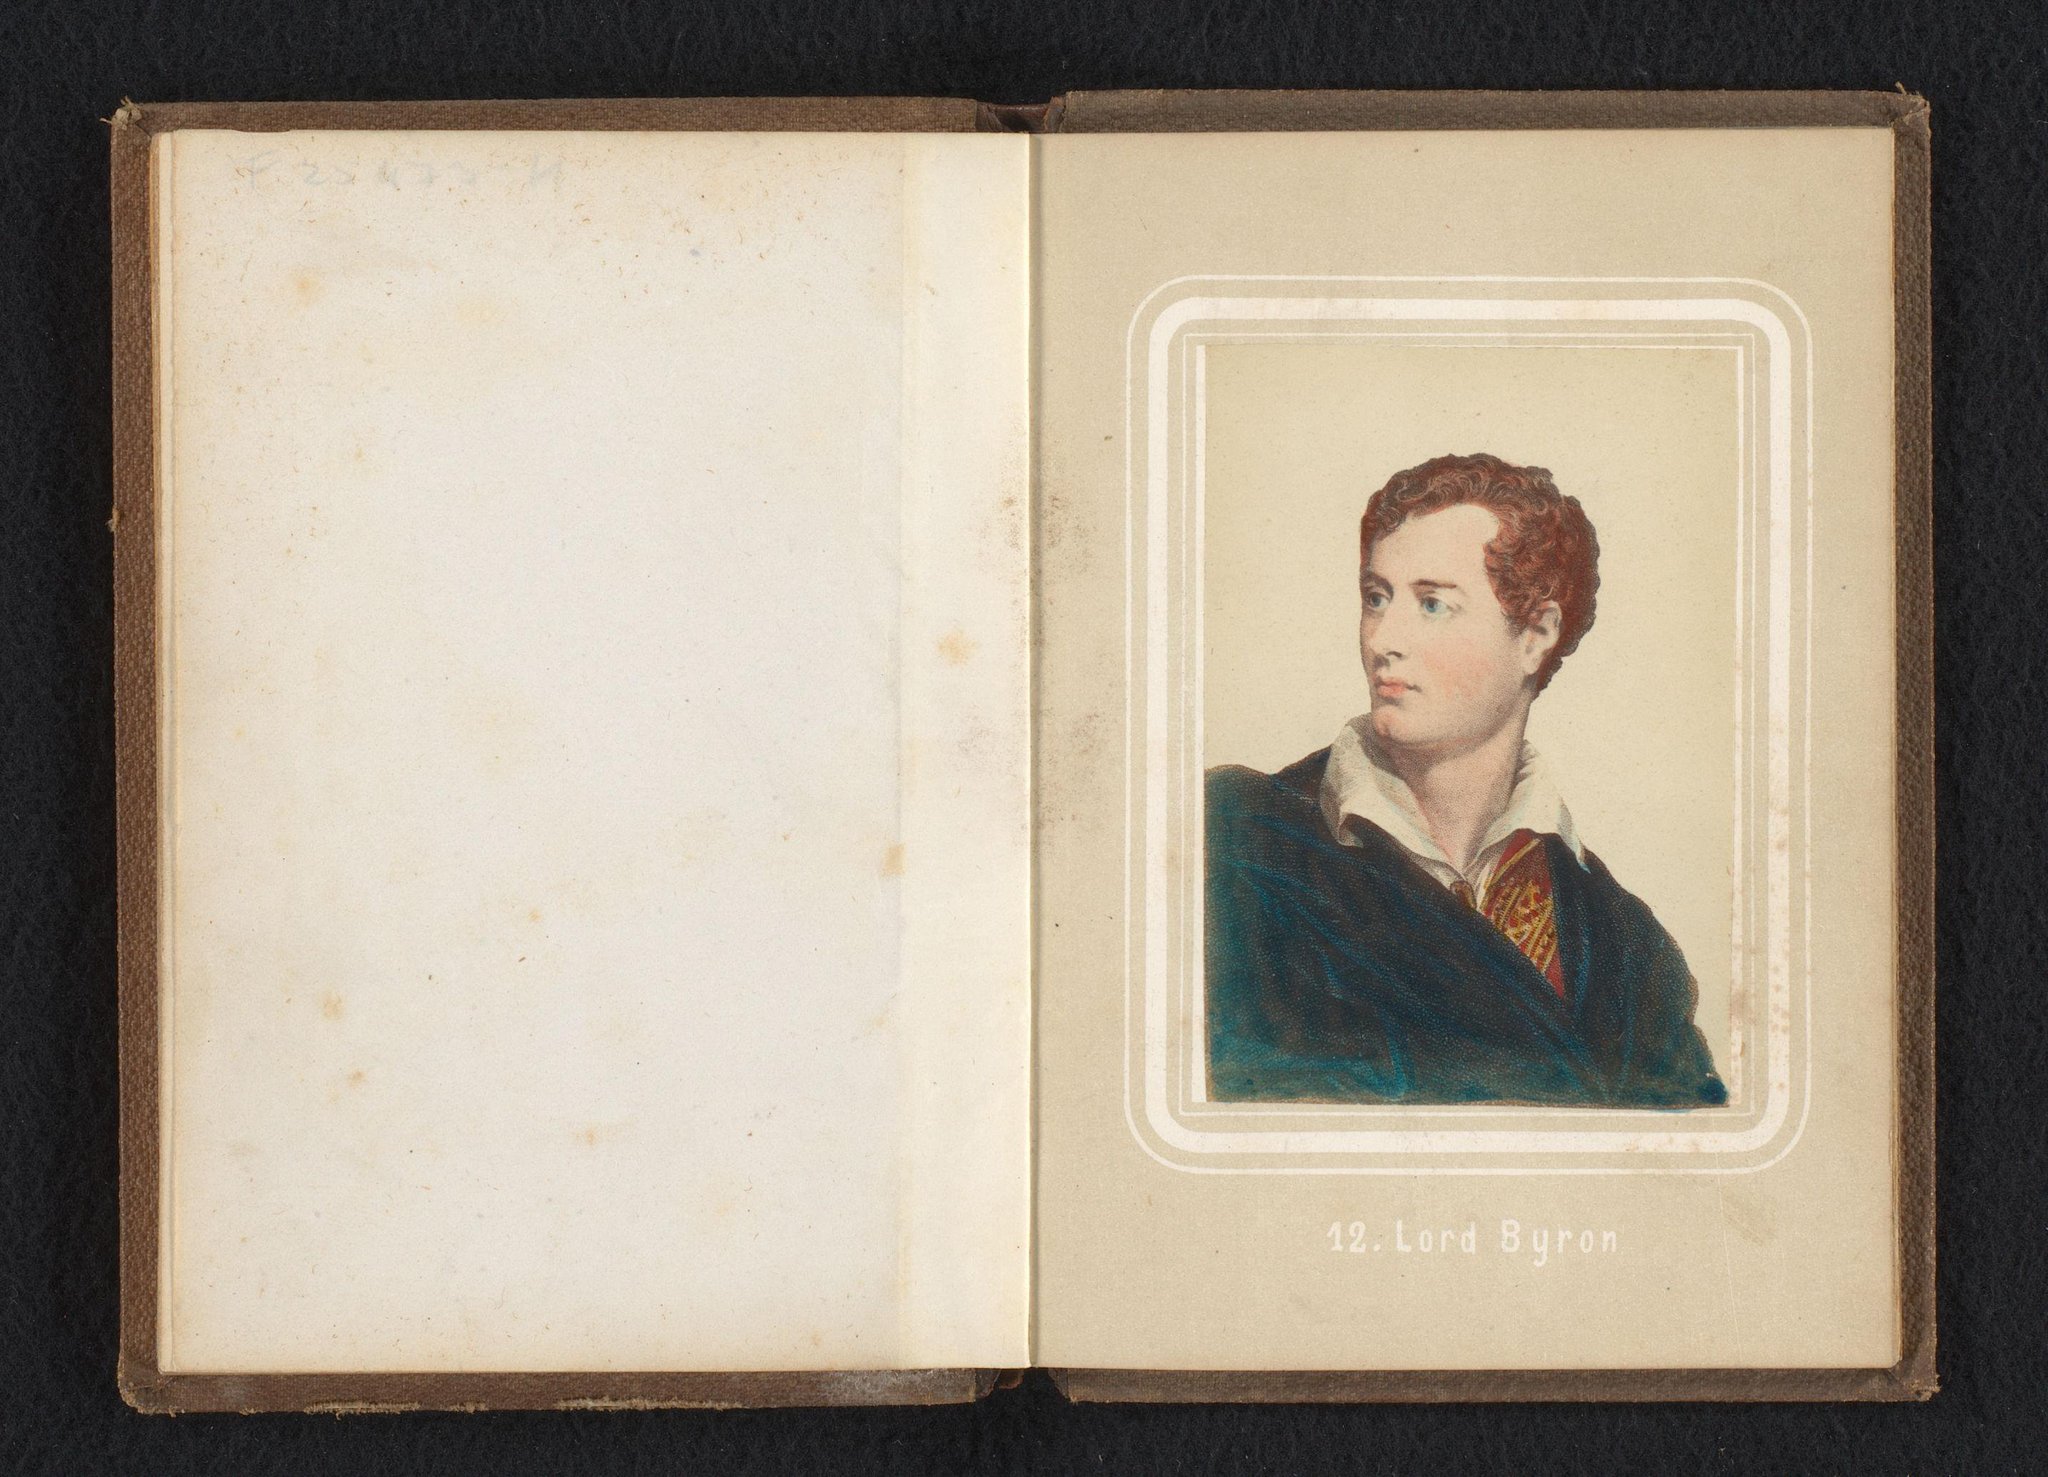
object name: photograph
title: Fotoreproductie van een getekend portret van de dichter Lord Byron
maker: Anonymous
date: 1870-1890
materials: paper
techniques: albumen print, hand coloring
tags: london, lord byron, historical persons, portrait of a writer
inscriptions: number: ‘12.’